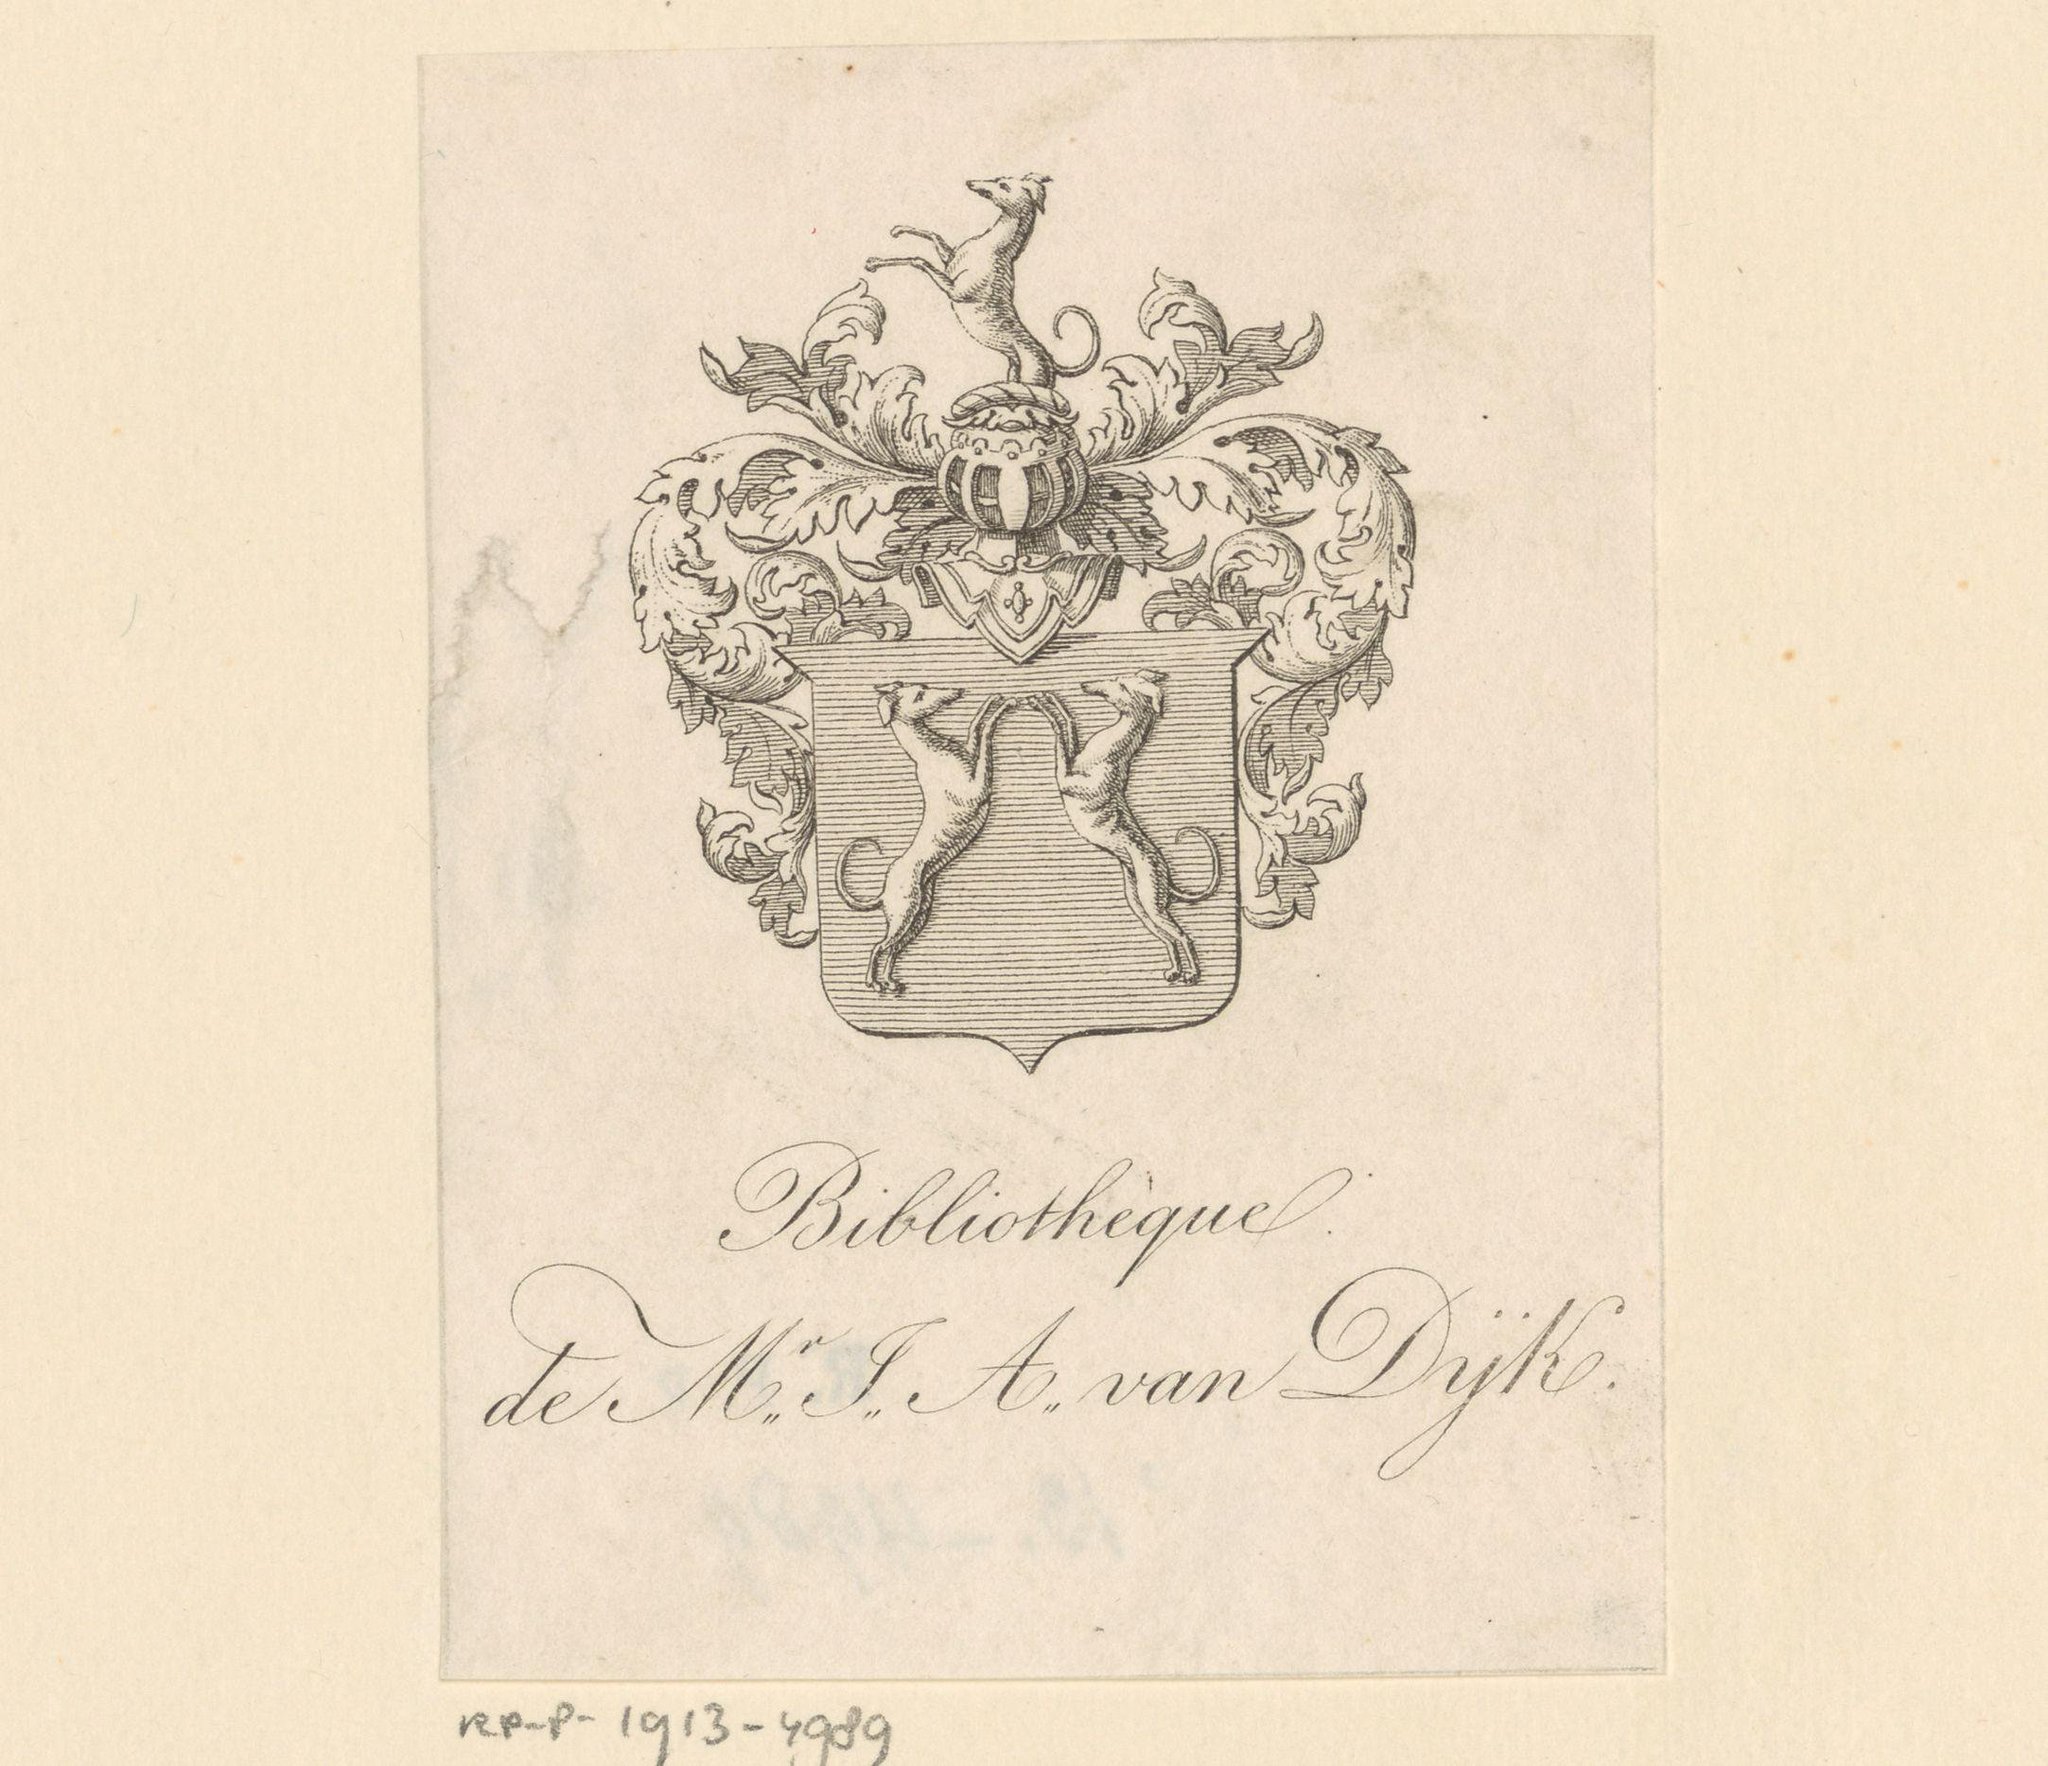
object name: bookplate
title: Ex libris van J.A. van Dijk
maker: Anonymous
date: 1800-1899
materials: paper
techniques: printing block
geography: netherlands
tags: armorial bearing, heraldry, dog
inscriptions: collector's mark: Lugt 2760, collector's mark: Lugt 2233